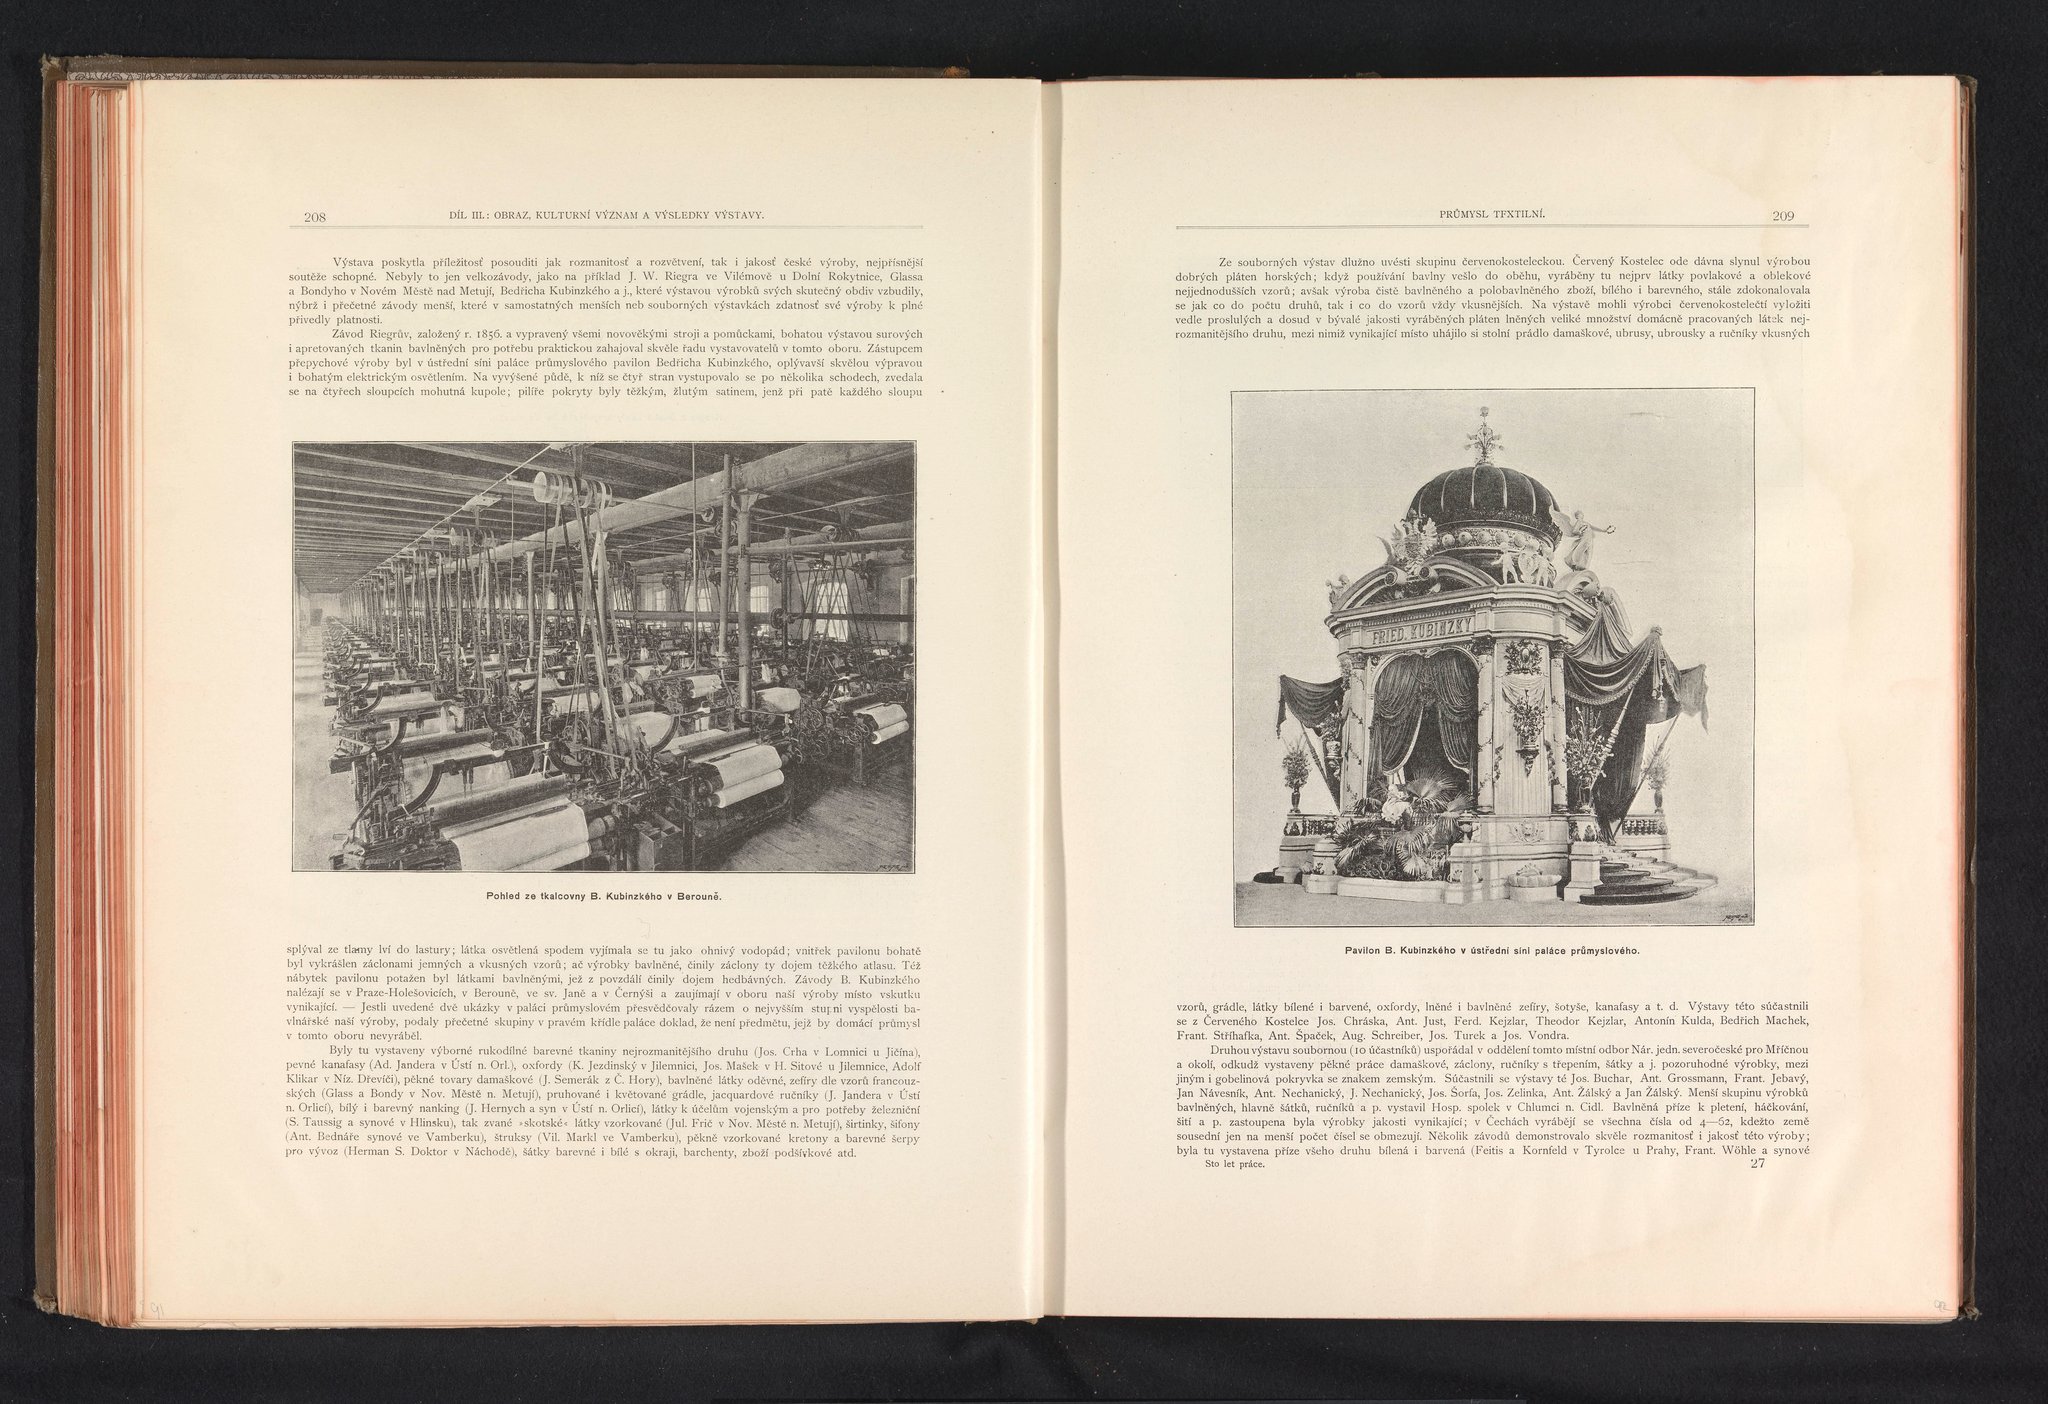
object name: page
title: Pohled ze tkalcovy B. Kubinzkého Beroune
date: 1890-1895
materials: paper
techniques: autotype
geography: prague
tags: interior ~ representation of a building, textile industry and clothing industry